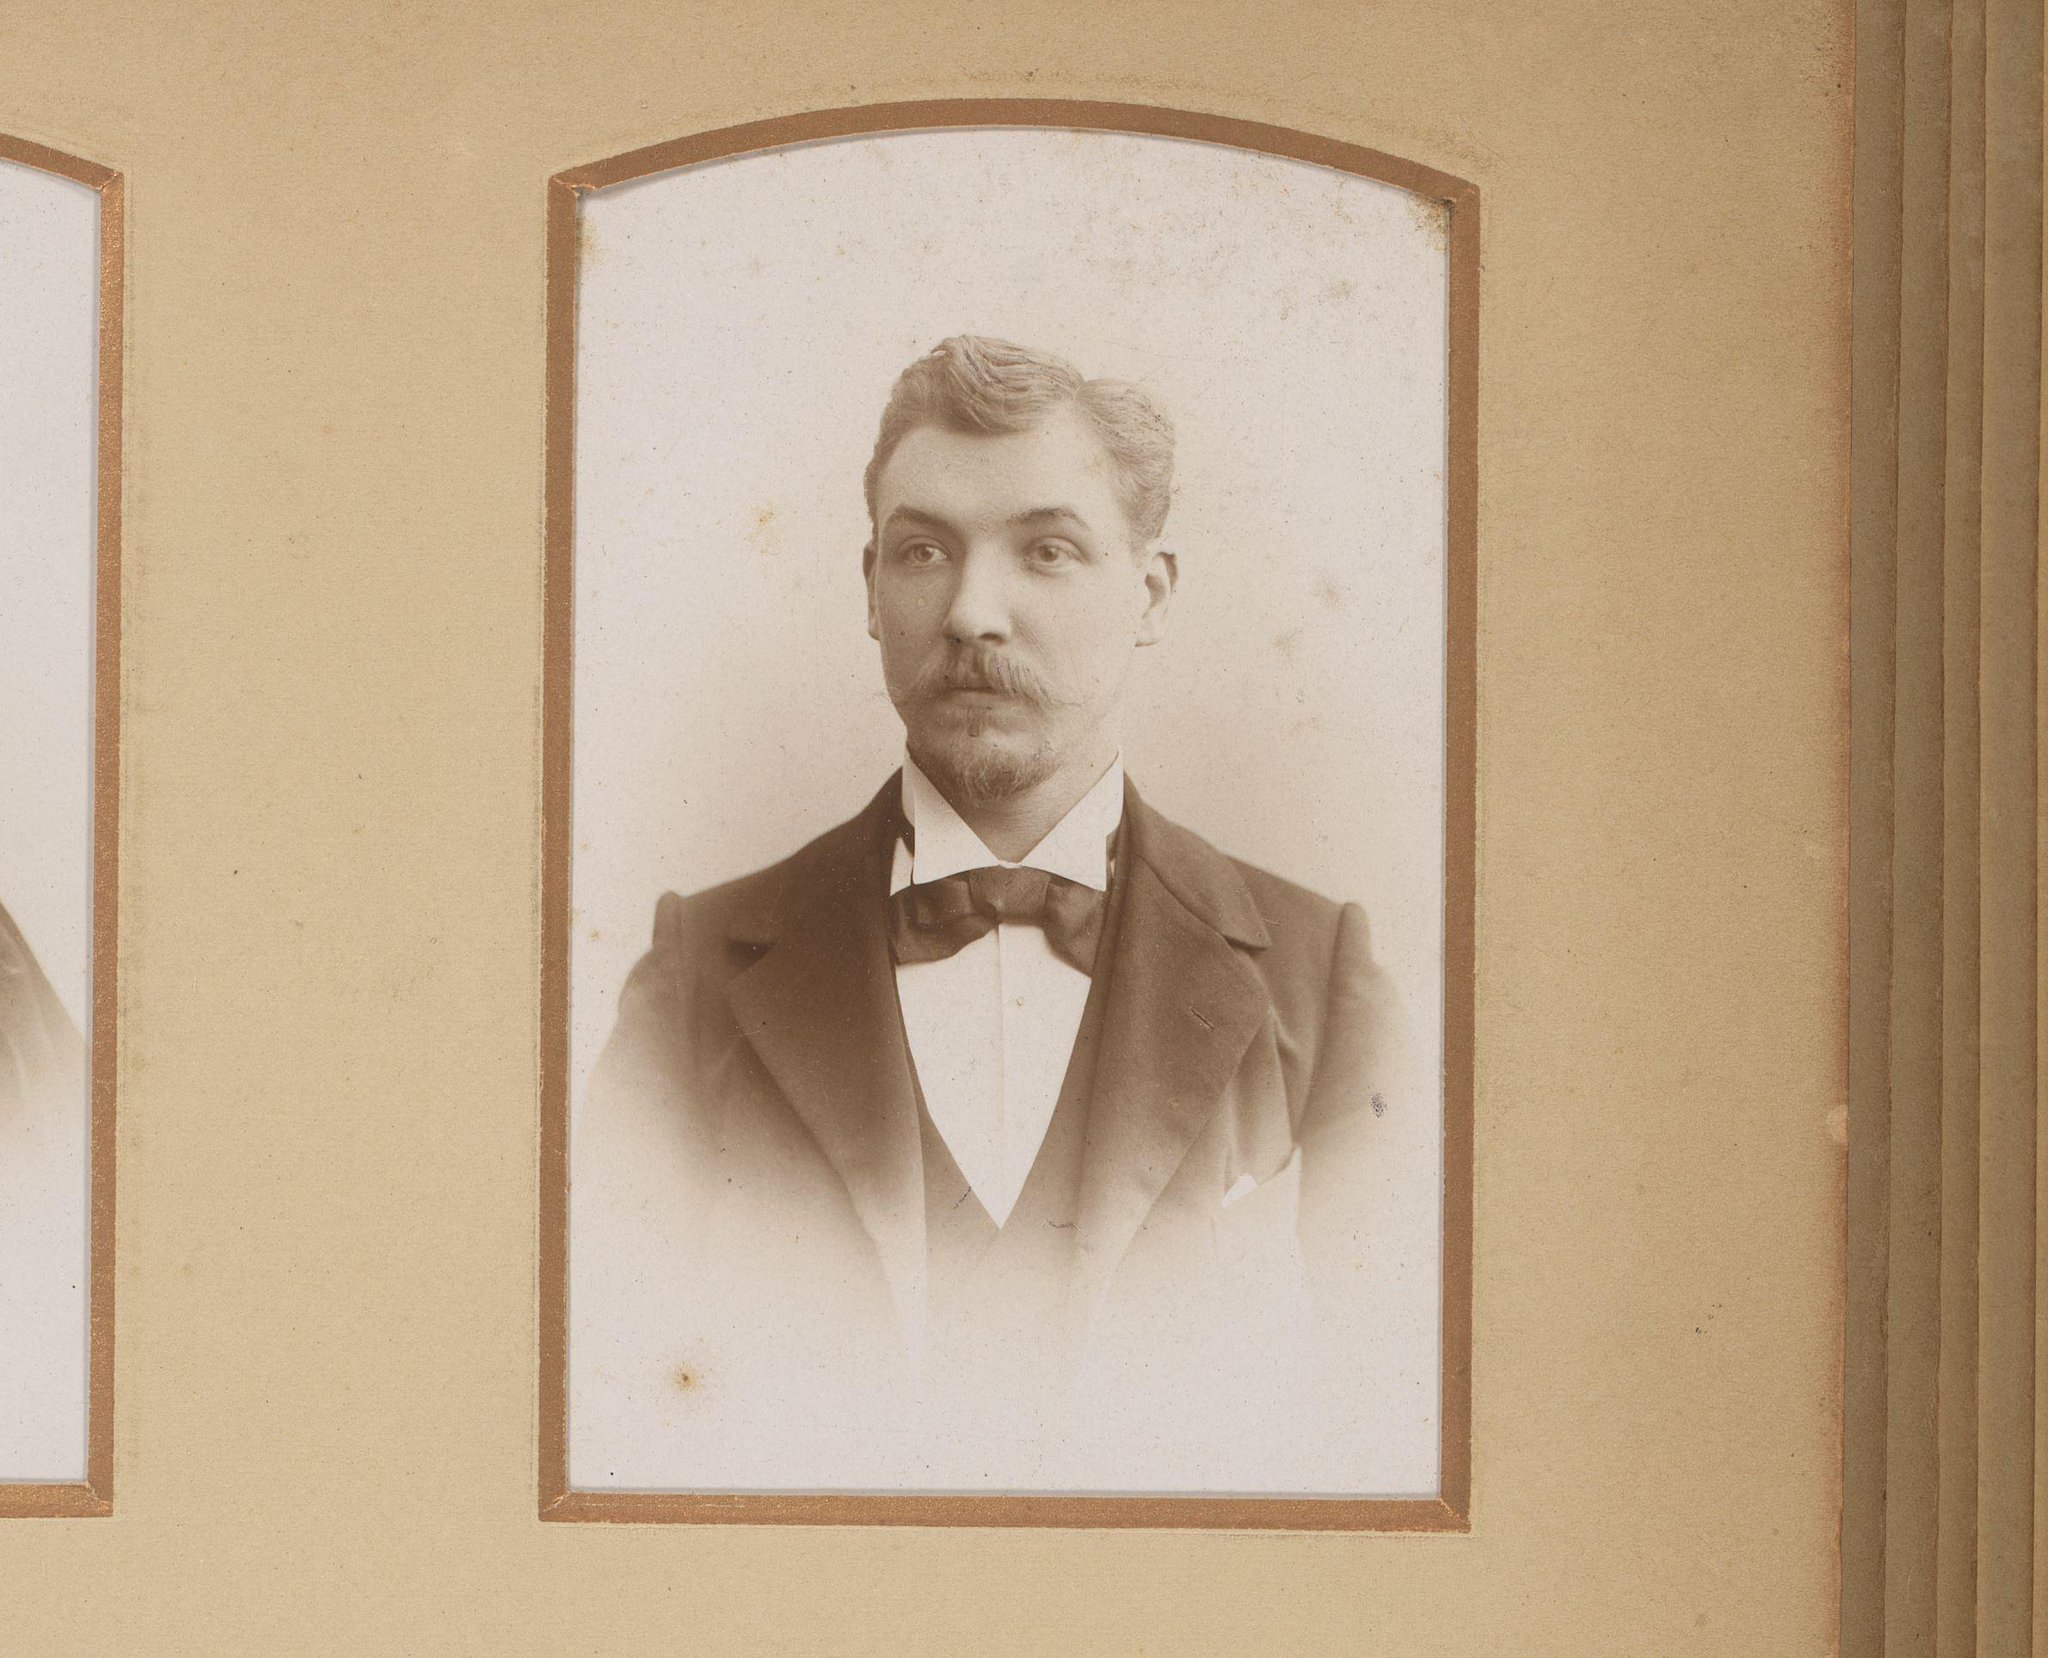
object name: photograph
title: Portret van een man met snor, sik en vlinderstrik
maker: albert greiner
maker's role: fotograaf, fotostudio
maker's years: 1833-1890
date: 1874-1887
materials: cardboard, photographic support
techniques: collodion silver print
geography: amsterdam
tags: moustache, historical persons, beard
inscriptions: inscription: ‘(...)/ ALBERT GREINER/ Photograaf van wijlen Z.M. den/ Koning Willem III en H.M. de Koningin Weduwe/ AMSTERDAM/ NIEUWENDIJK 89./ Specialiteit in Vergrootingen.’